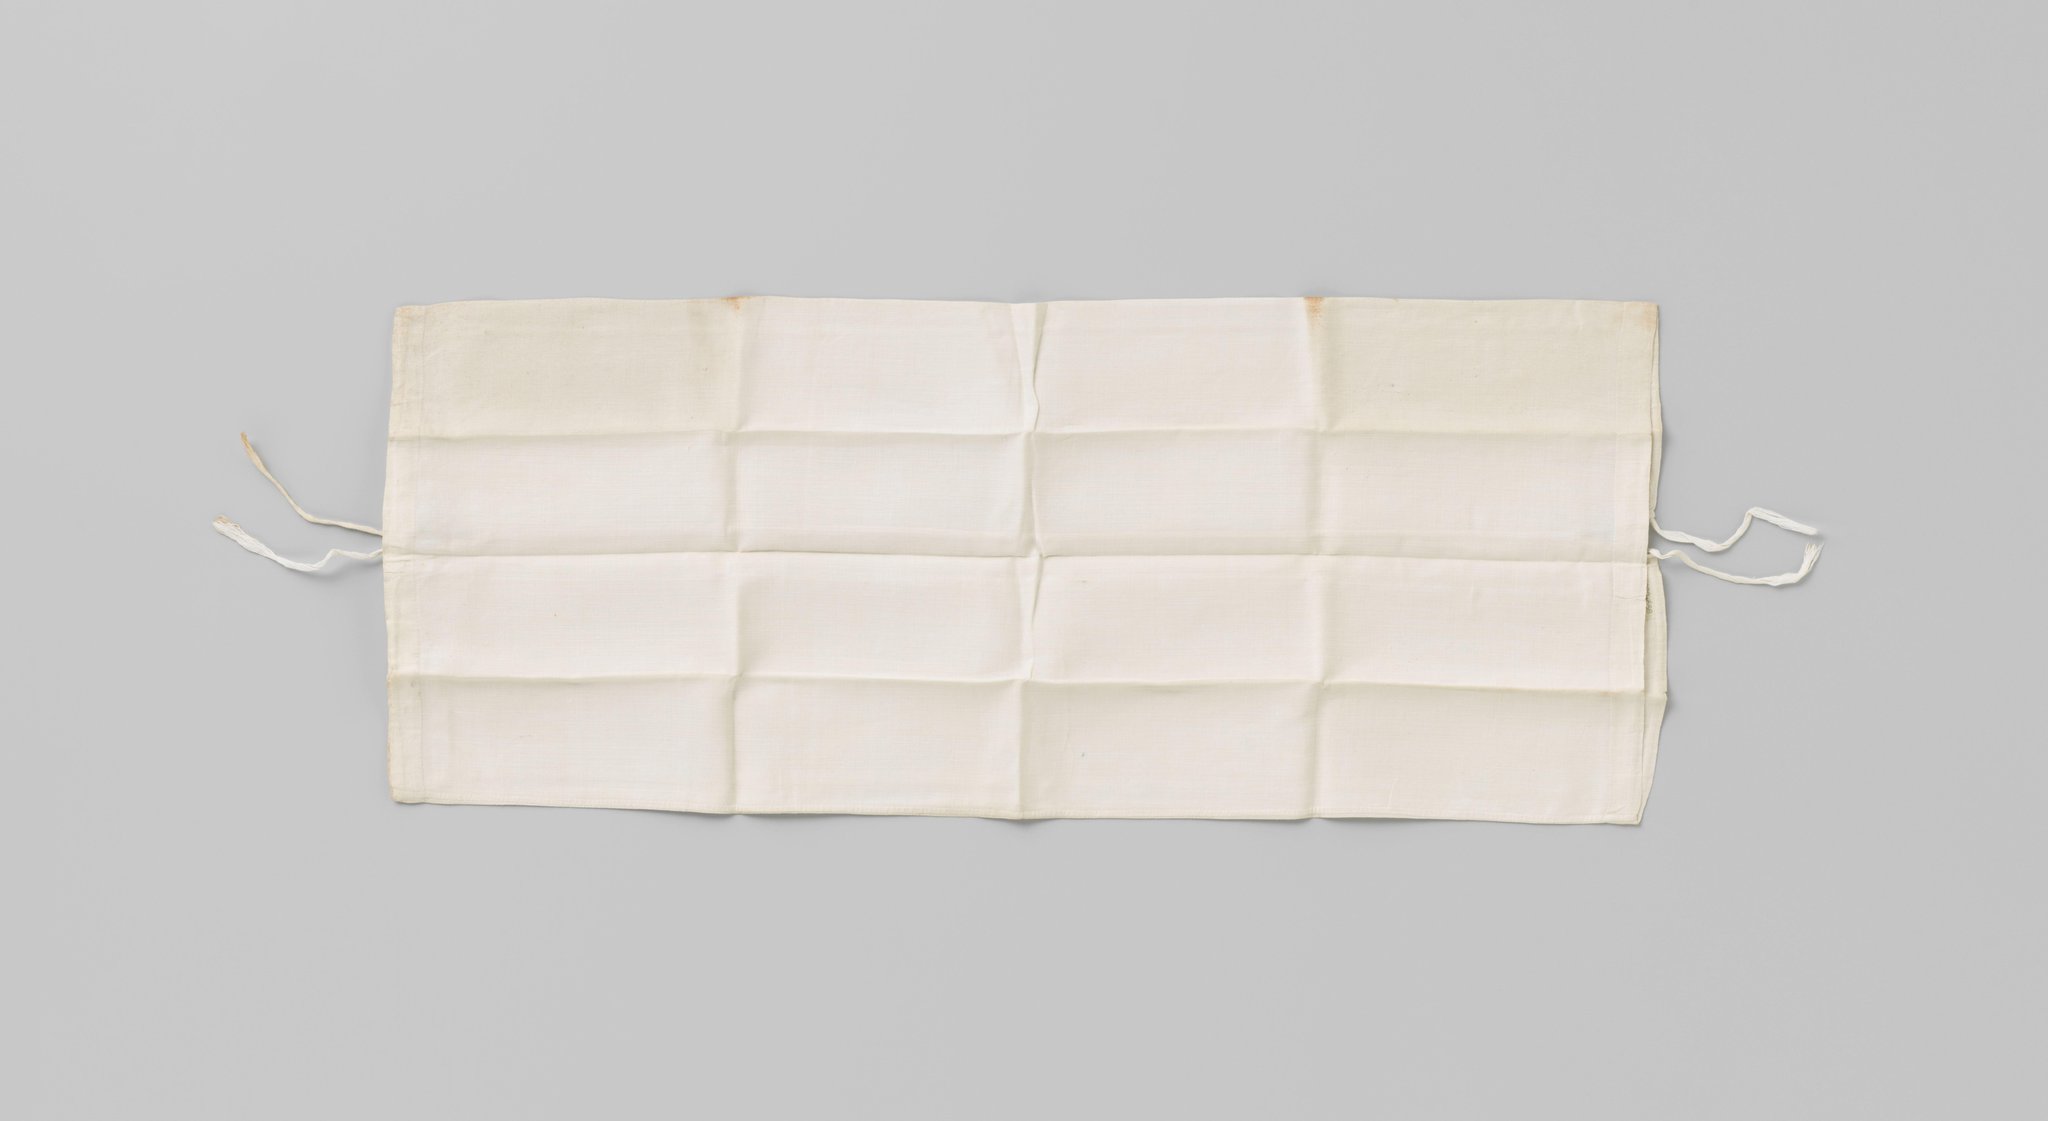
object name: rolsloop, rolkussenovertrek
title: Rolsloop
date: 1852-1872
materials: linen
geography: northern netherlands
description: Rolsloop van linnen met open uiteinden, merk IS3.